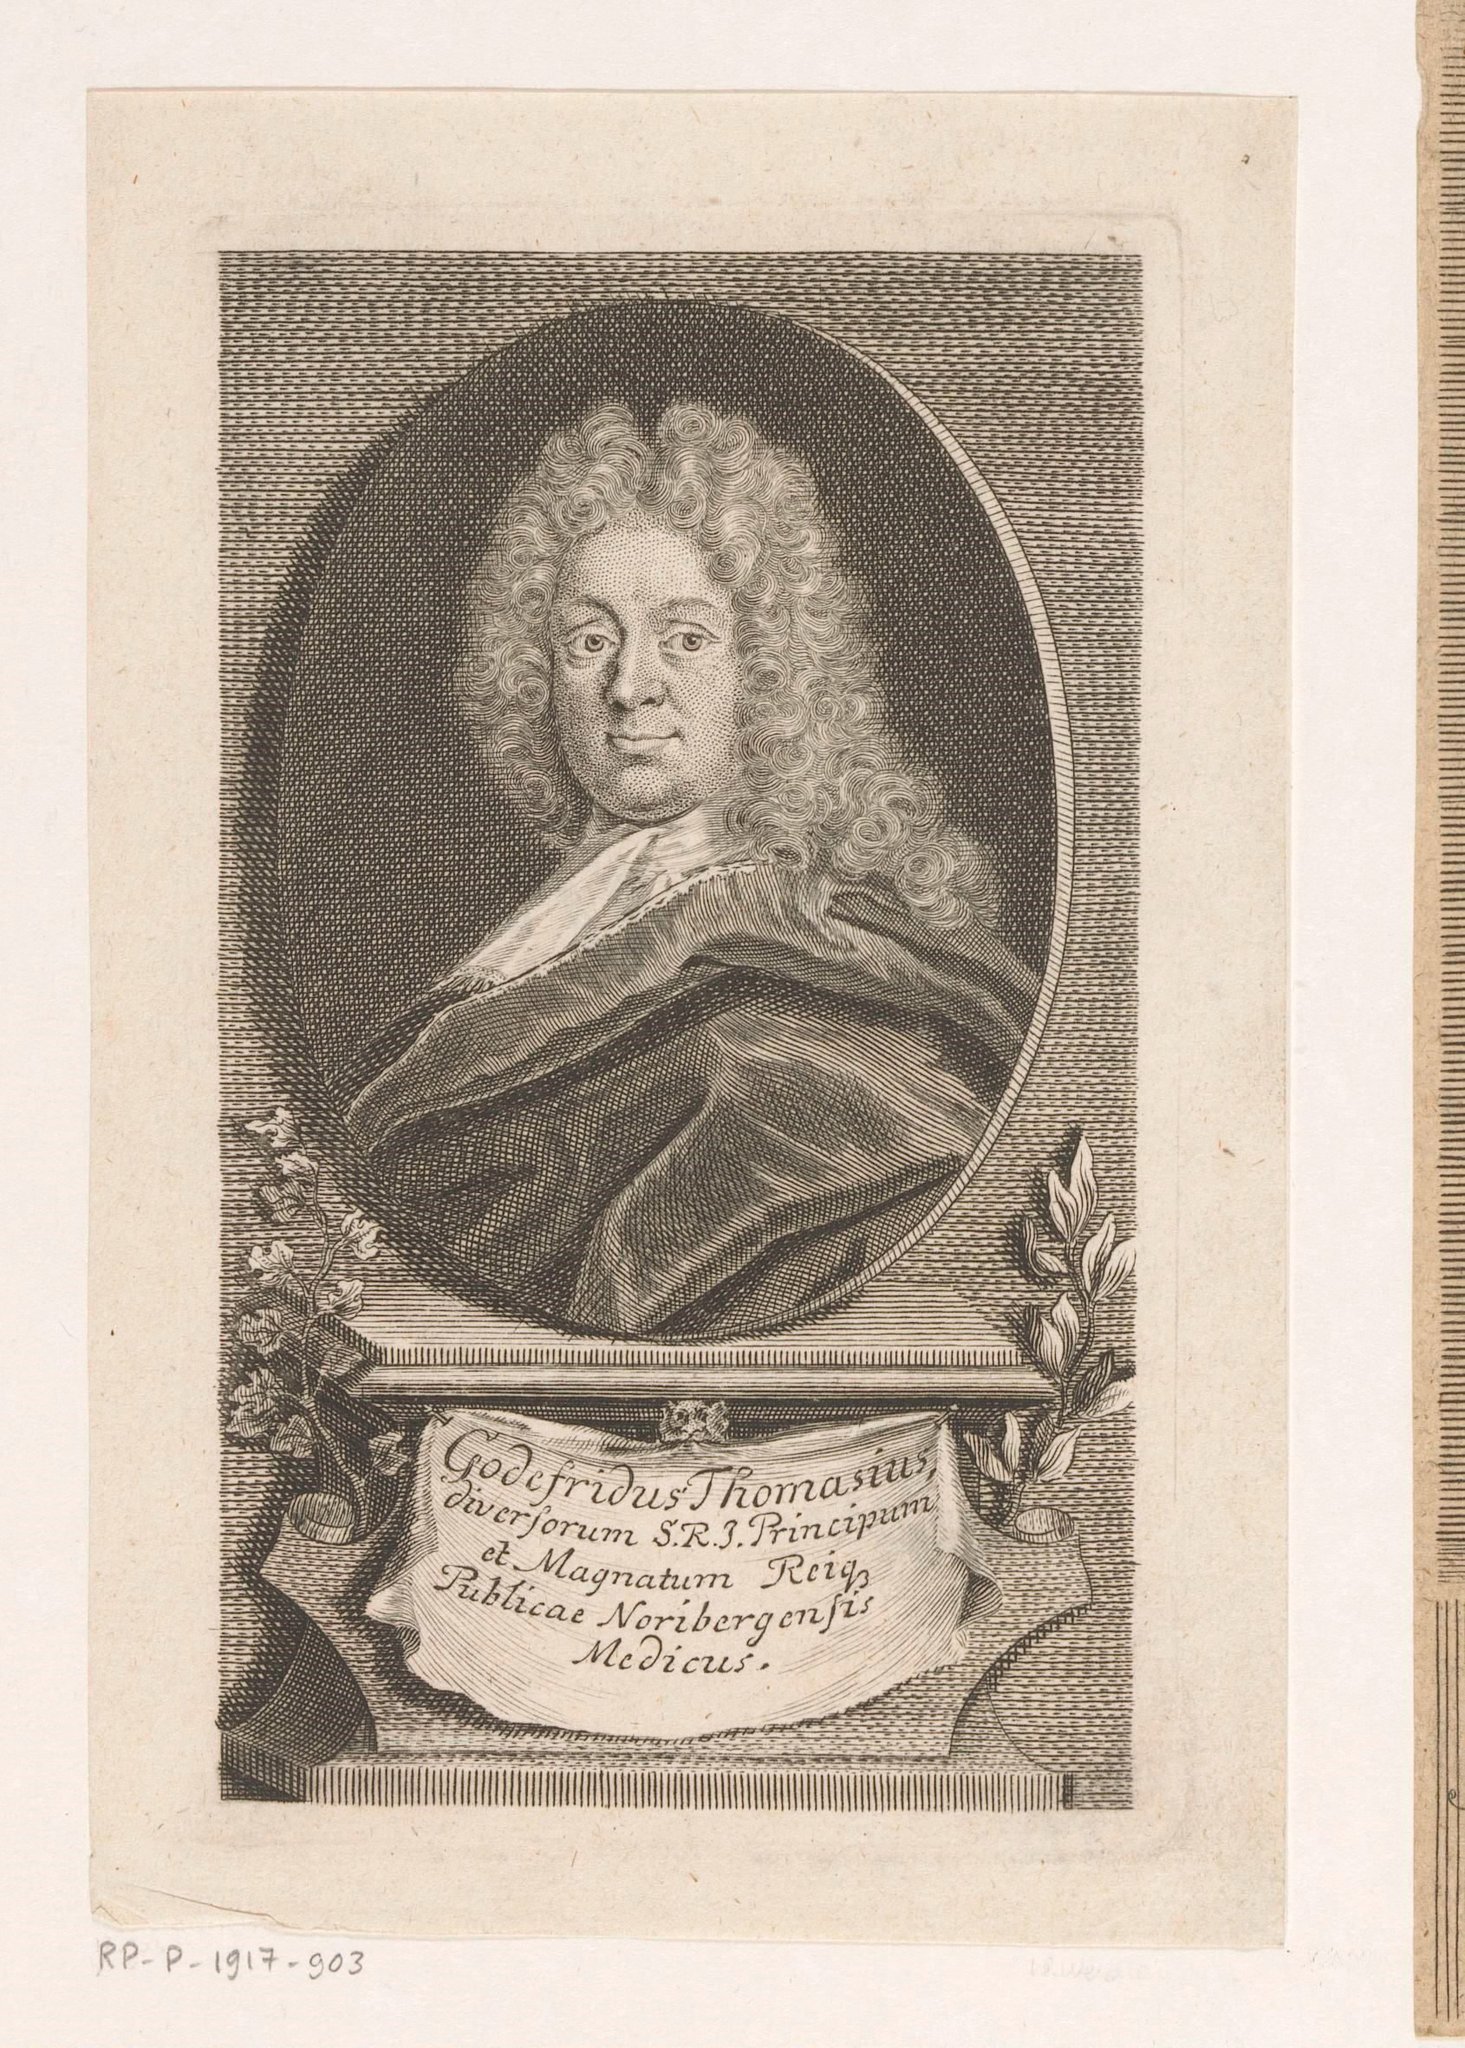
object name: print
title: Portret van Gottfried Thomasius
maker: martin bernigeroth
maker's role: print maker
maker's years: 1670-1733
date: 1712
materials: paper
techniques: engraving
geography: leipzig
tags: gottfried thomasius, historical persons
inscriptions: collector's mark: Lugt 2228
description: Prent ook gebruikt in: Deutsche Acta Eruditorum (...). dl. 5. Leipzig: Johann Gottlieb Gleditsch, 1712.